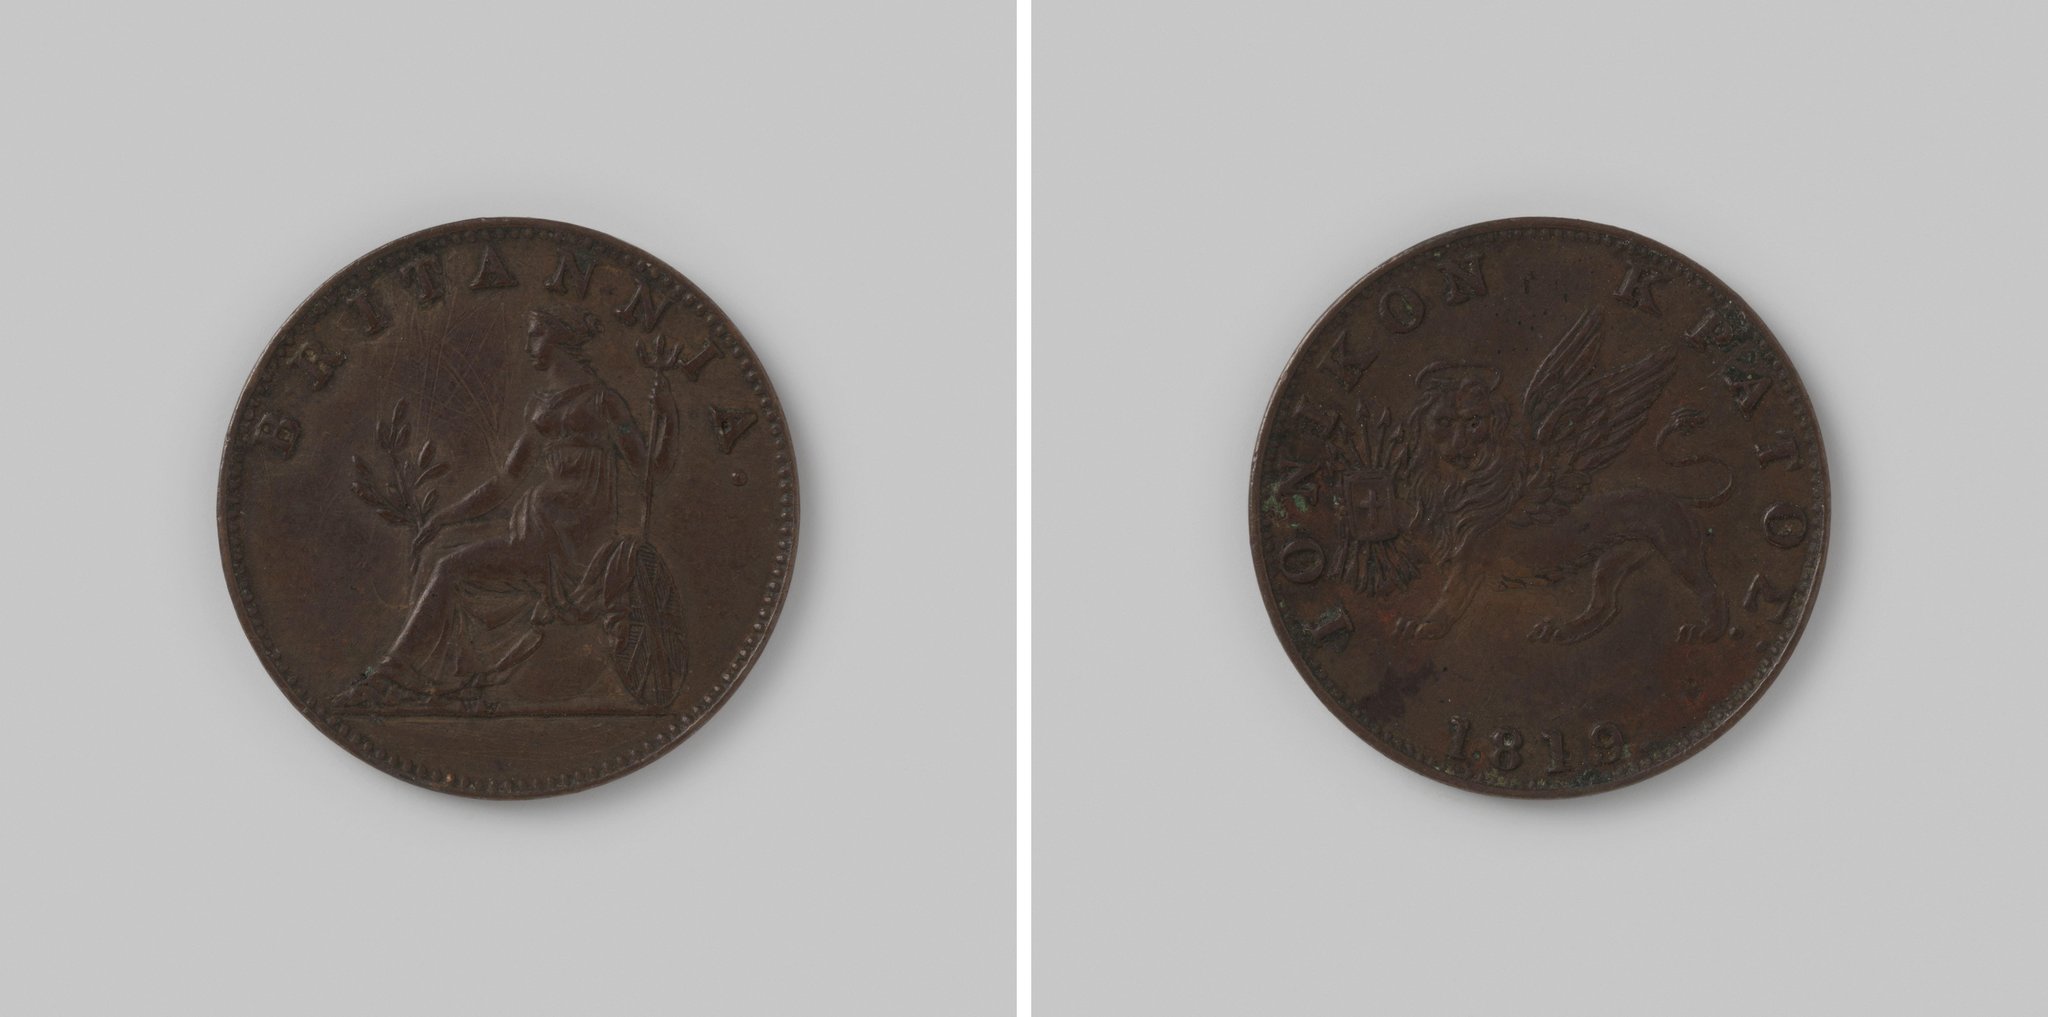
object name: coin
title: 2 lepta of ½ obool uit de Ionische eilanden onder heerschappij van Groot-Brittannië,1819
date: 1819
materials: copper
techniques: striking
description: Koperen munt. Voorzijde: Brittannia naar links, gezeten op een rots, waartegen een schild, met in haar linkerhand een drietand en in haar rechter een tak. Keerzijde: gevleugelde leeuw met in zijn rechterpoot het evangelie, omgeven door een pijlenbundel. Jaartal onderaan. Gladde rand.